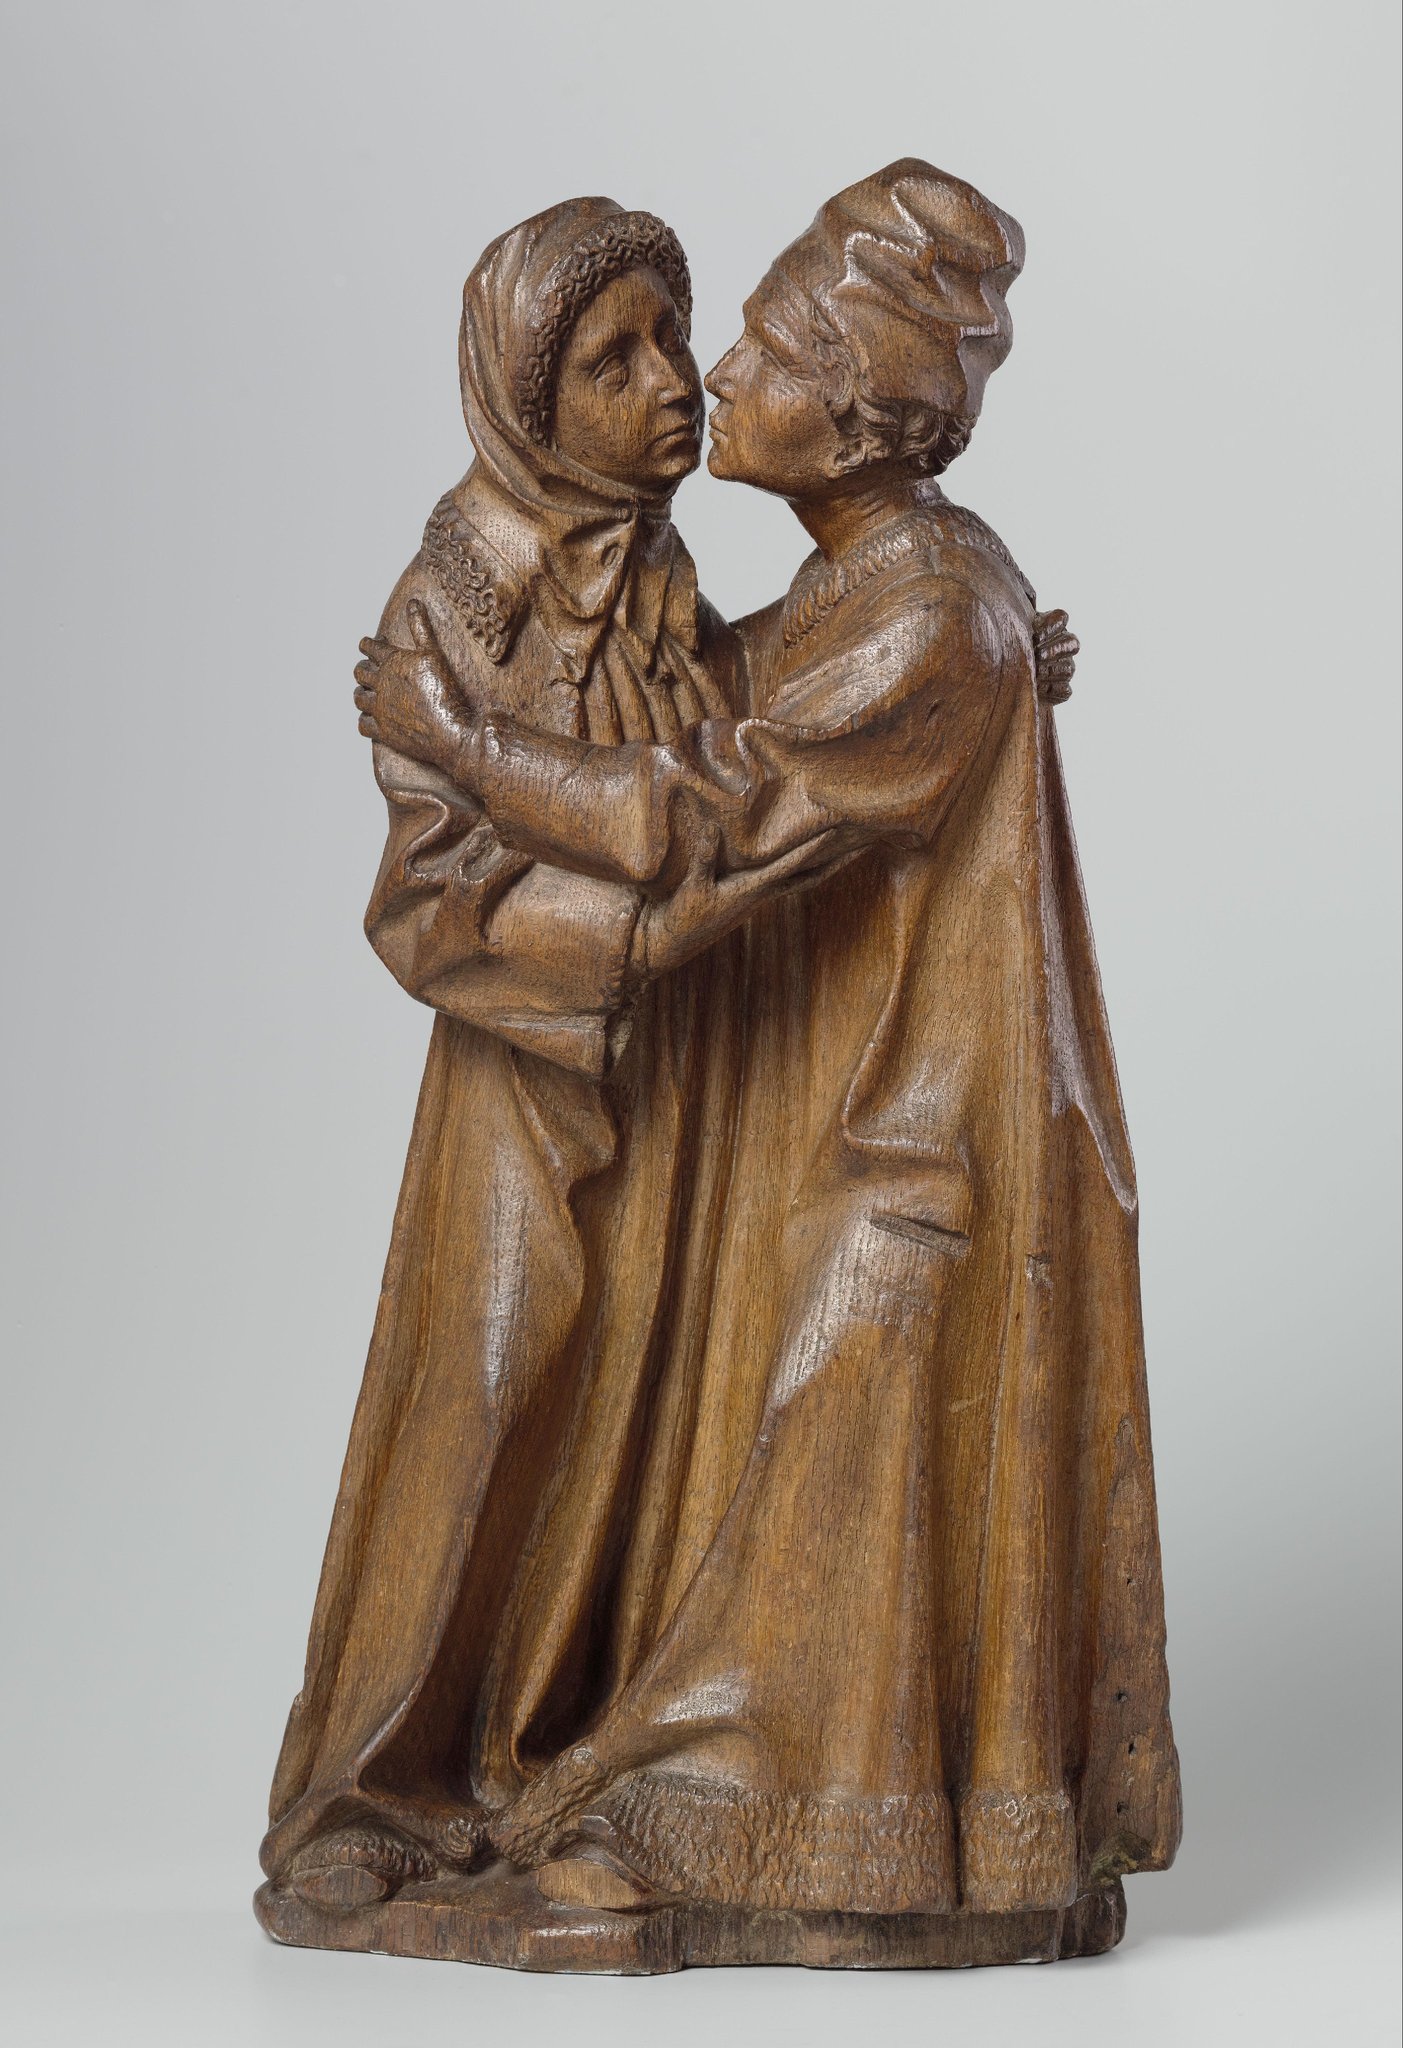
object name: sculpture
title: The Meeting of Joachim and Anne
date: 1470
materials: wood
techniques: polychromy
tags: meeting of anna and joachim at the golden gate; they usually embrace or kiss each other (immaculate conception of mary)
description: Joachim and Anna had long been childless, until one day Anna’s prayers were answered and she miraculously became pregnant with the Virgin Mary. Overjoyed by this news, the couple embraces each other tenderly. This intimate, almost timeless statue was once part of a large altar dedicated to the life of the Virgin.